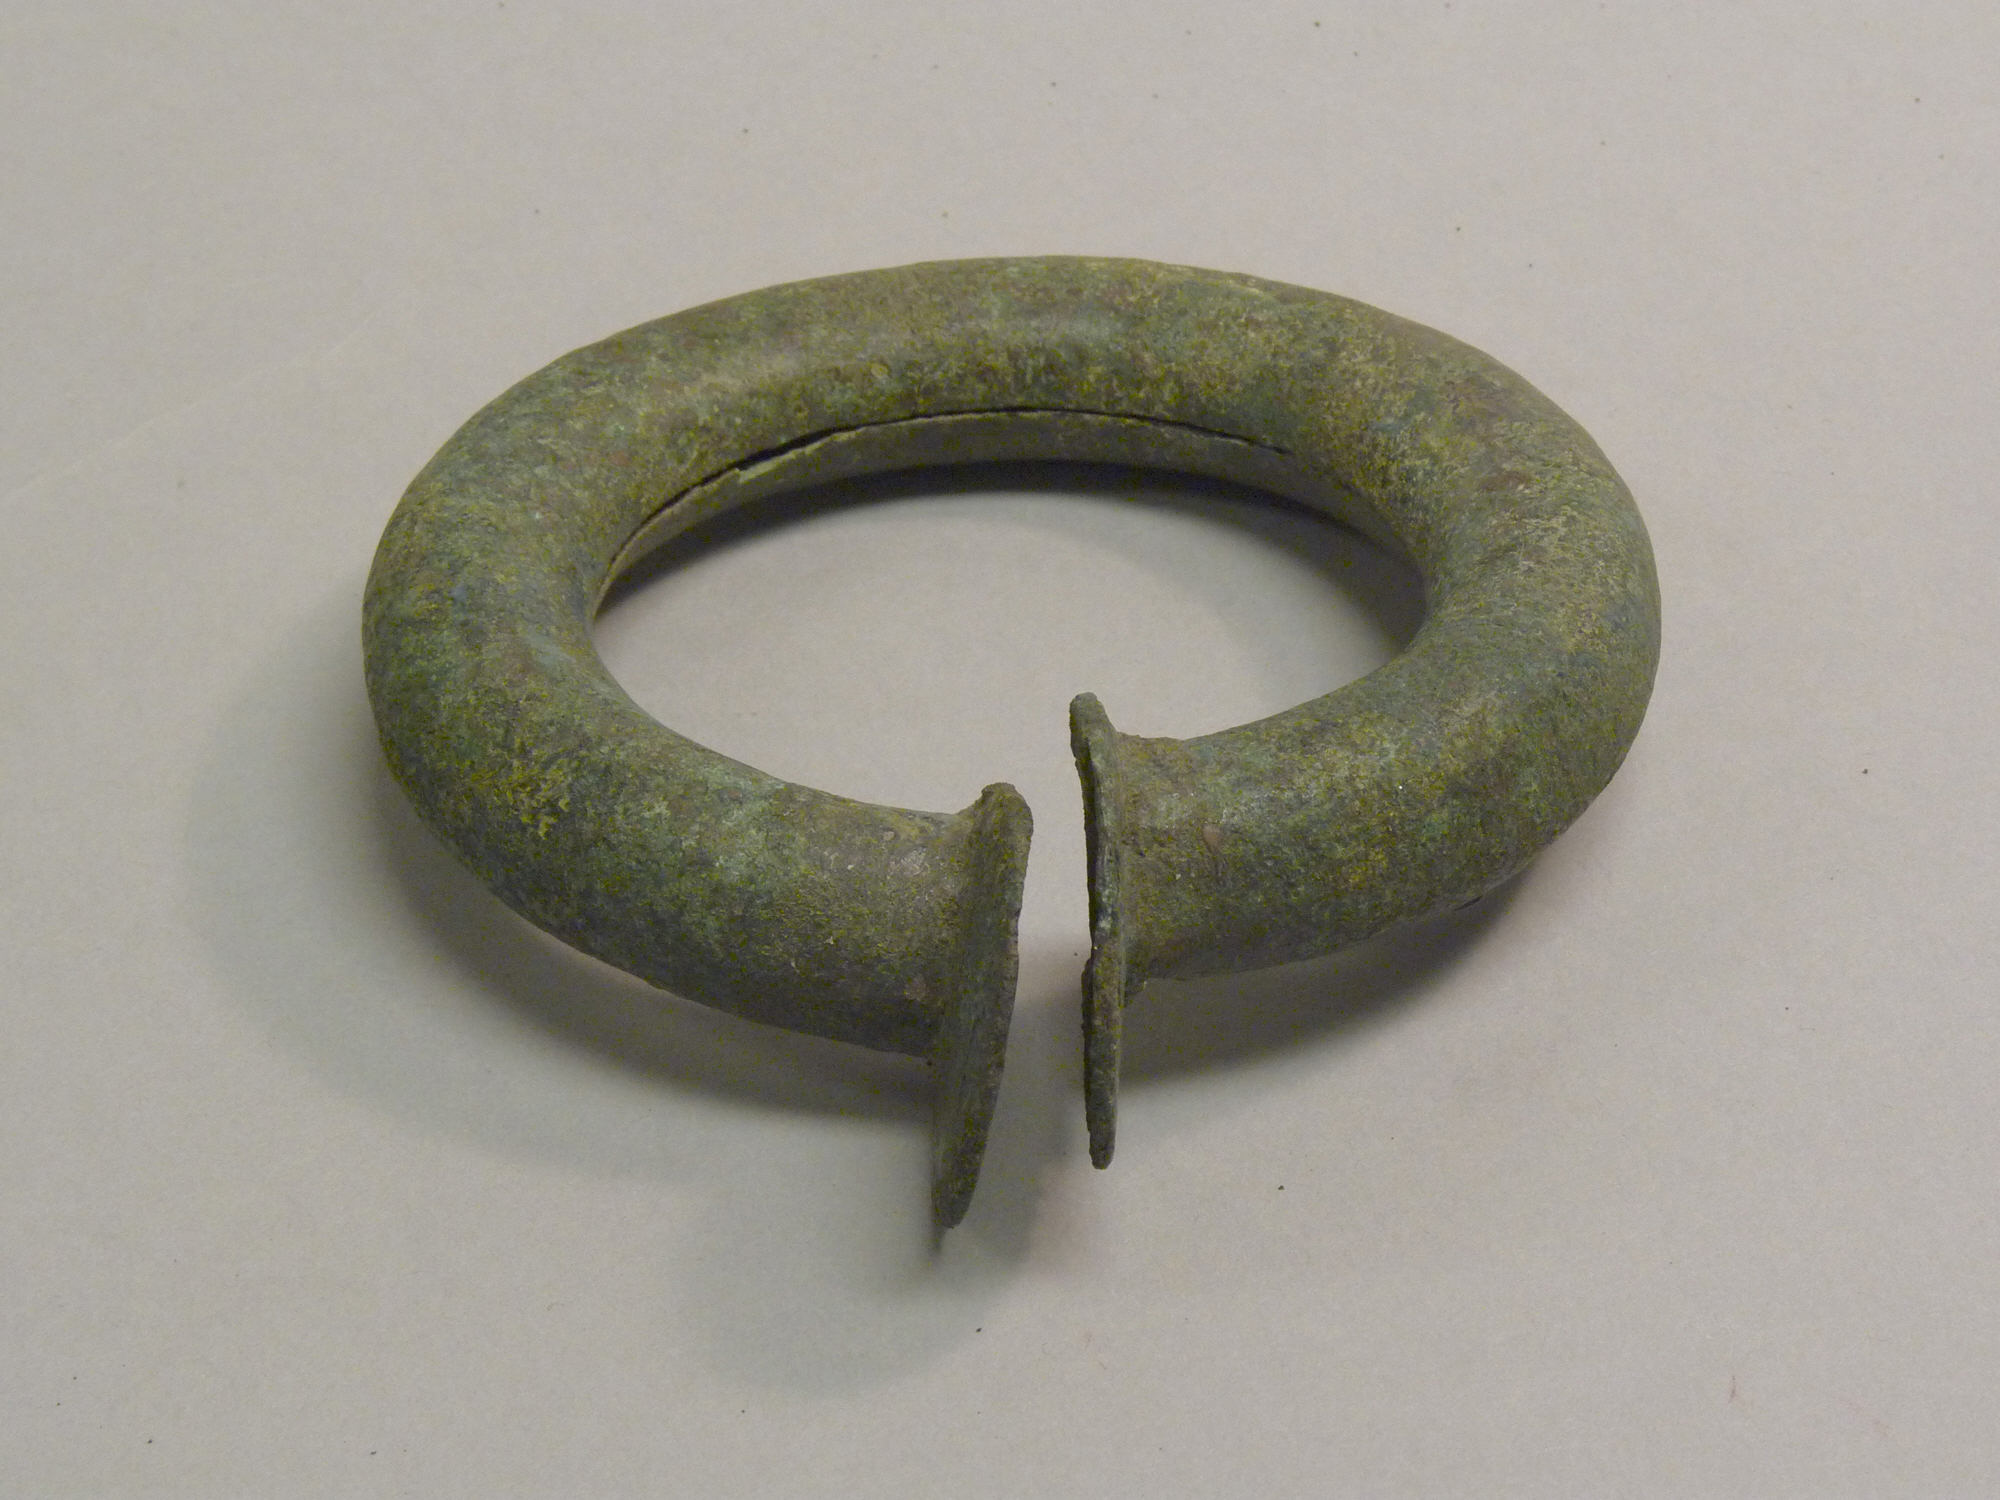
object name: anklet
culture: thai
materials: bronze